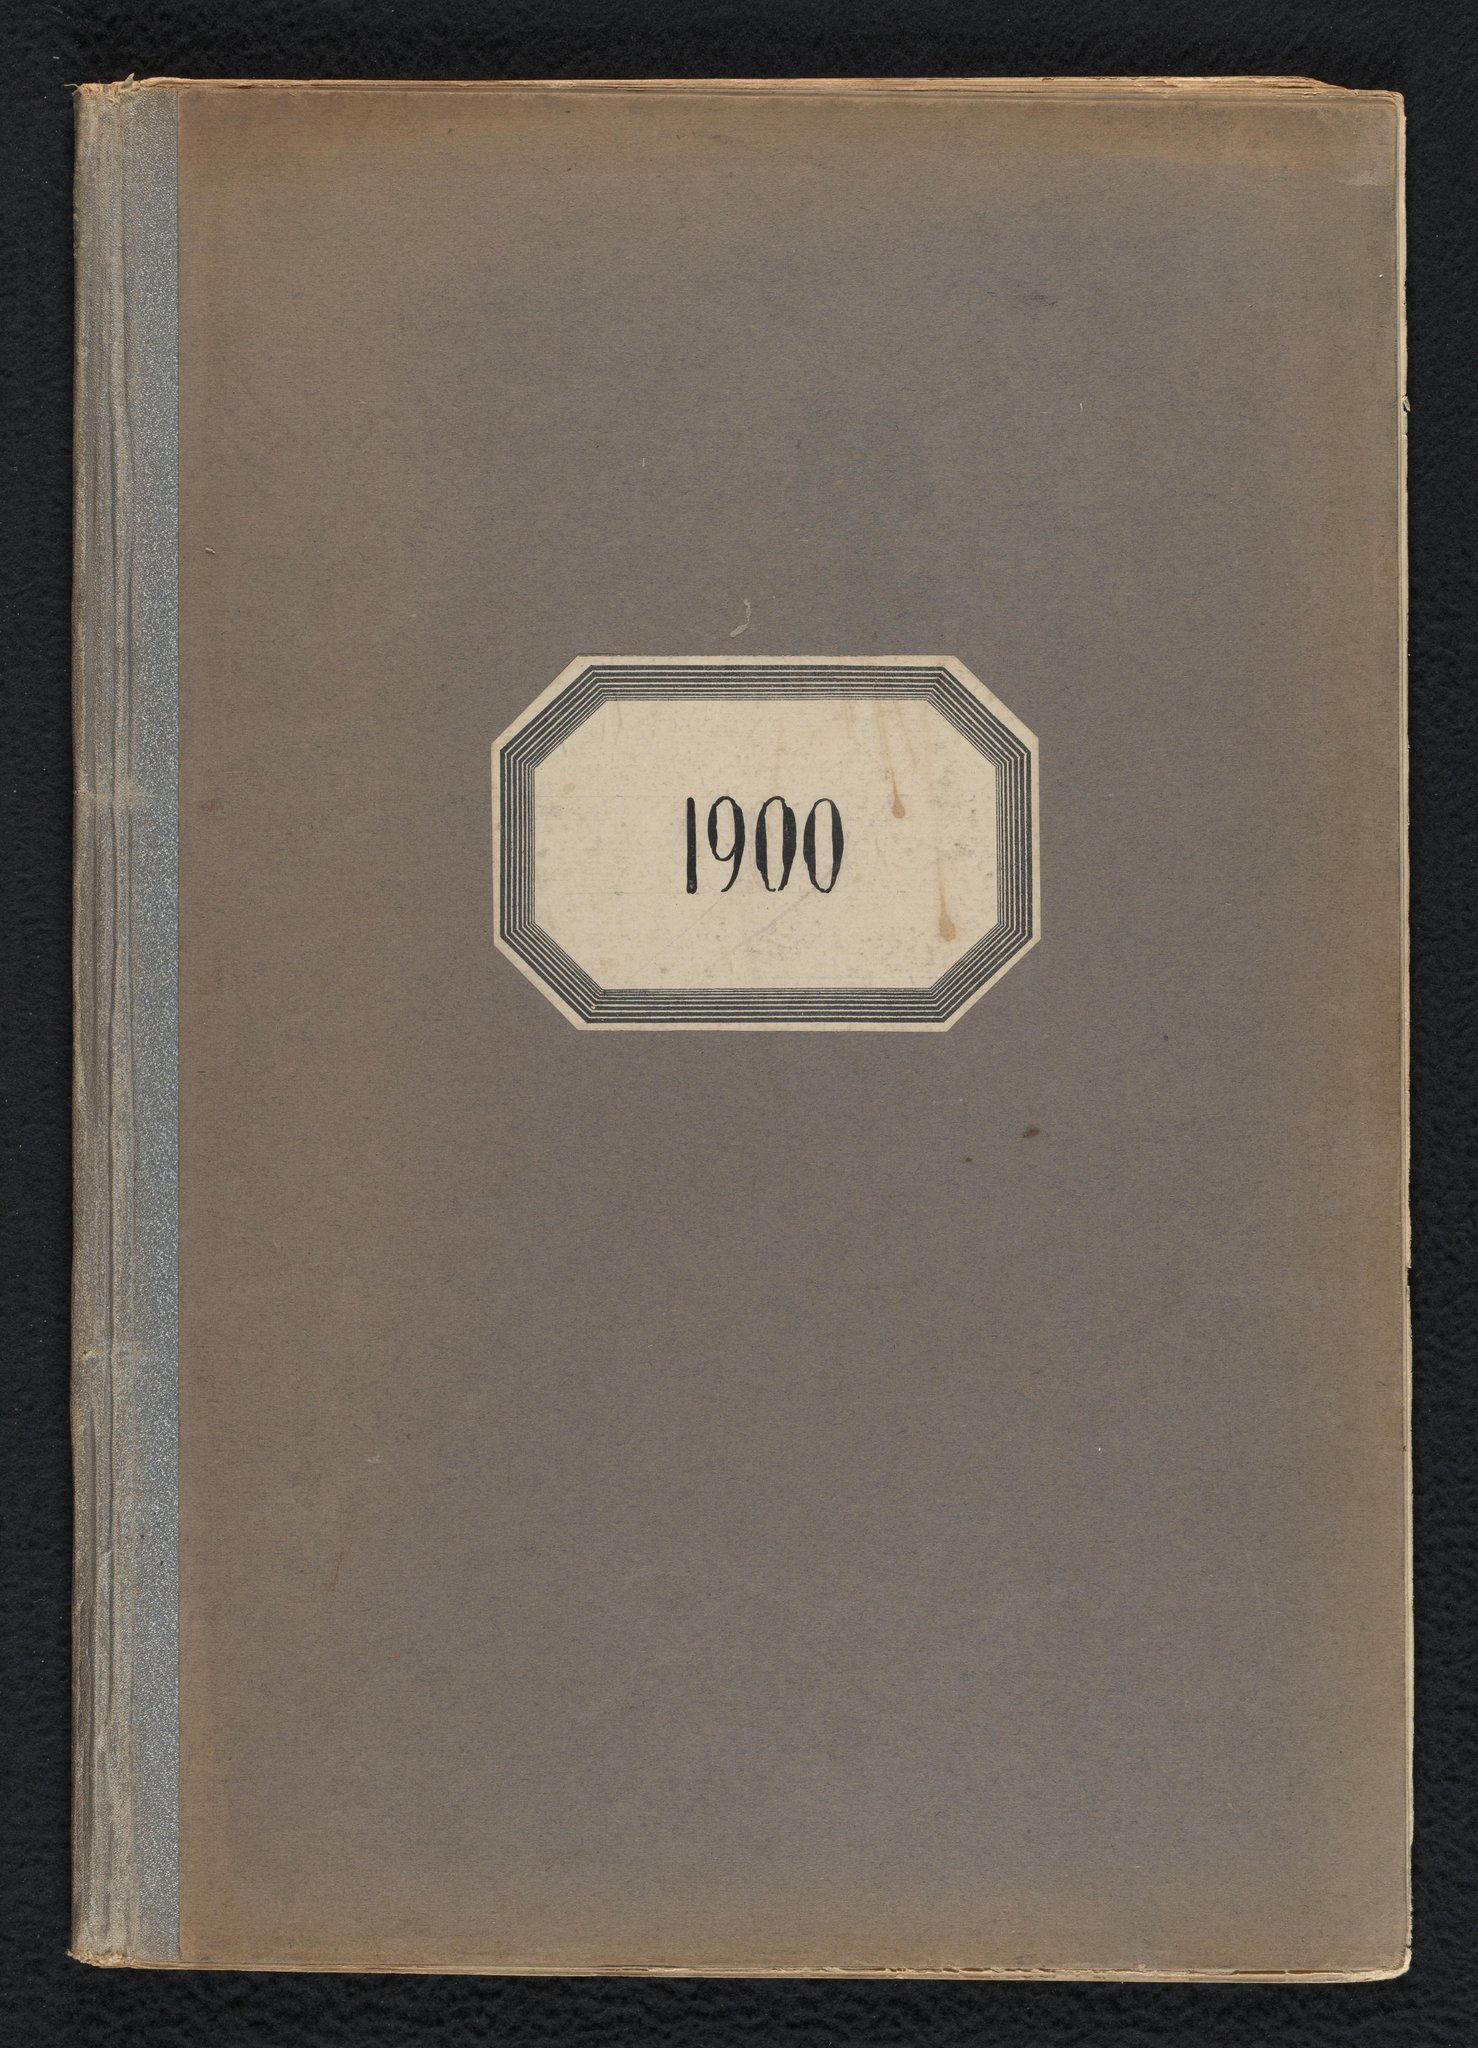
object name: cartoon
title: Spotprenten uit 'De Amsterdammer' van het jaar 1900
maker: johan braakensiek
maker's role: draughtsman, print maker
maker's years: 1858-1940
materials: paper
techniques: lithograph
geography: netherlands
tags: political caricatures and satires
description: Bundel van 53 spotprenten van Braakensiek (en twee door Linse) gepubliceerd als bijvoegsel bij 'De Amsterdammer' in het jaar 1900. Bundel geplakt in slappe omslag van grijsgroen karton met handgeschreven etiket '1900'.